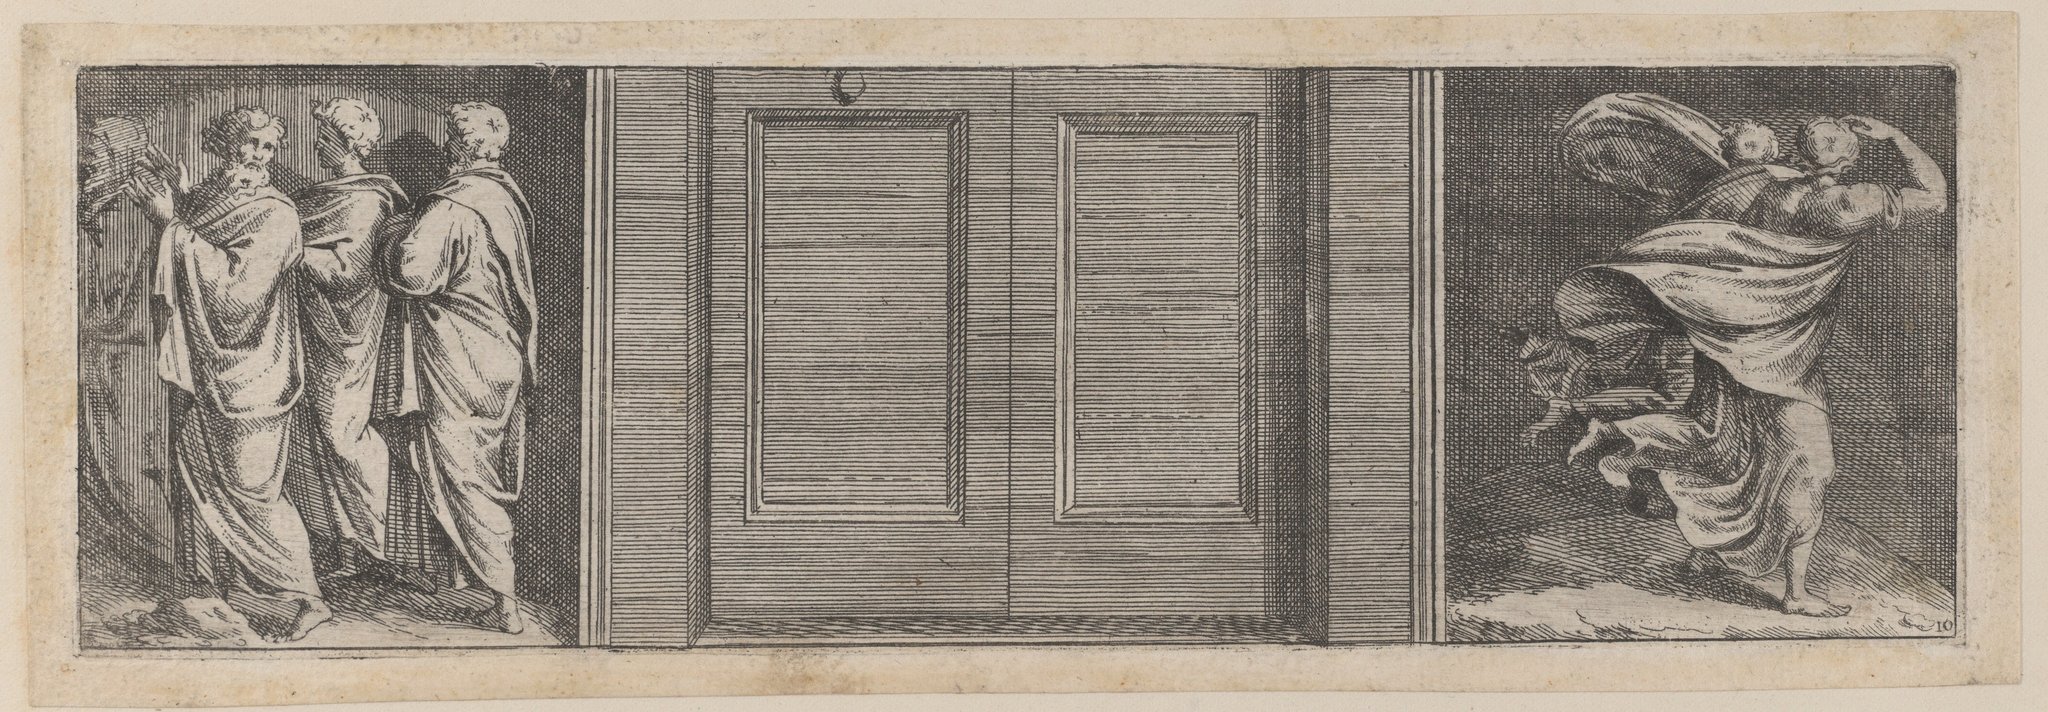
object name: print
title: Plate 10: Three figures at left and two figures running at right, after a lost fresco in the basamento of Bay 9 in the Vatican Loggia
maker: pietro santi bartoli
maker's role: artist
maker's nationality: italian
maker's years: 1615-1700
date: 1650-1677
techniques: etching